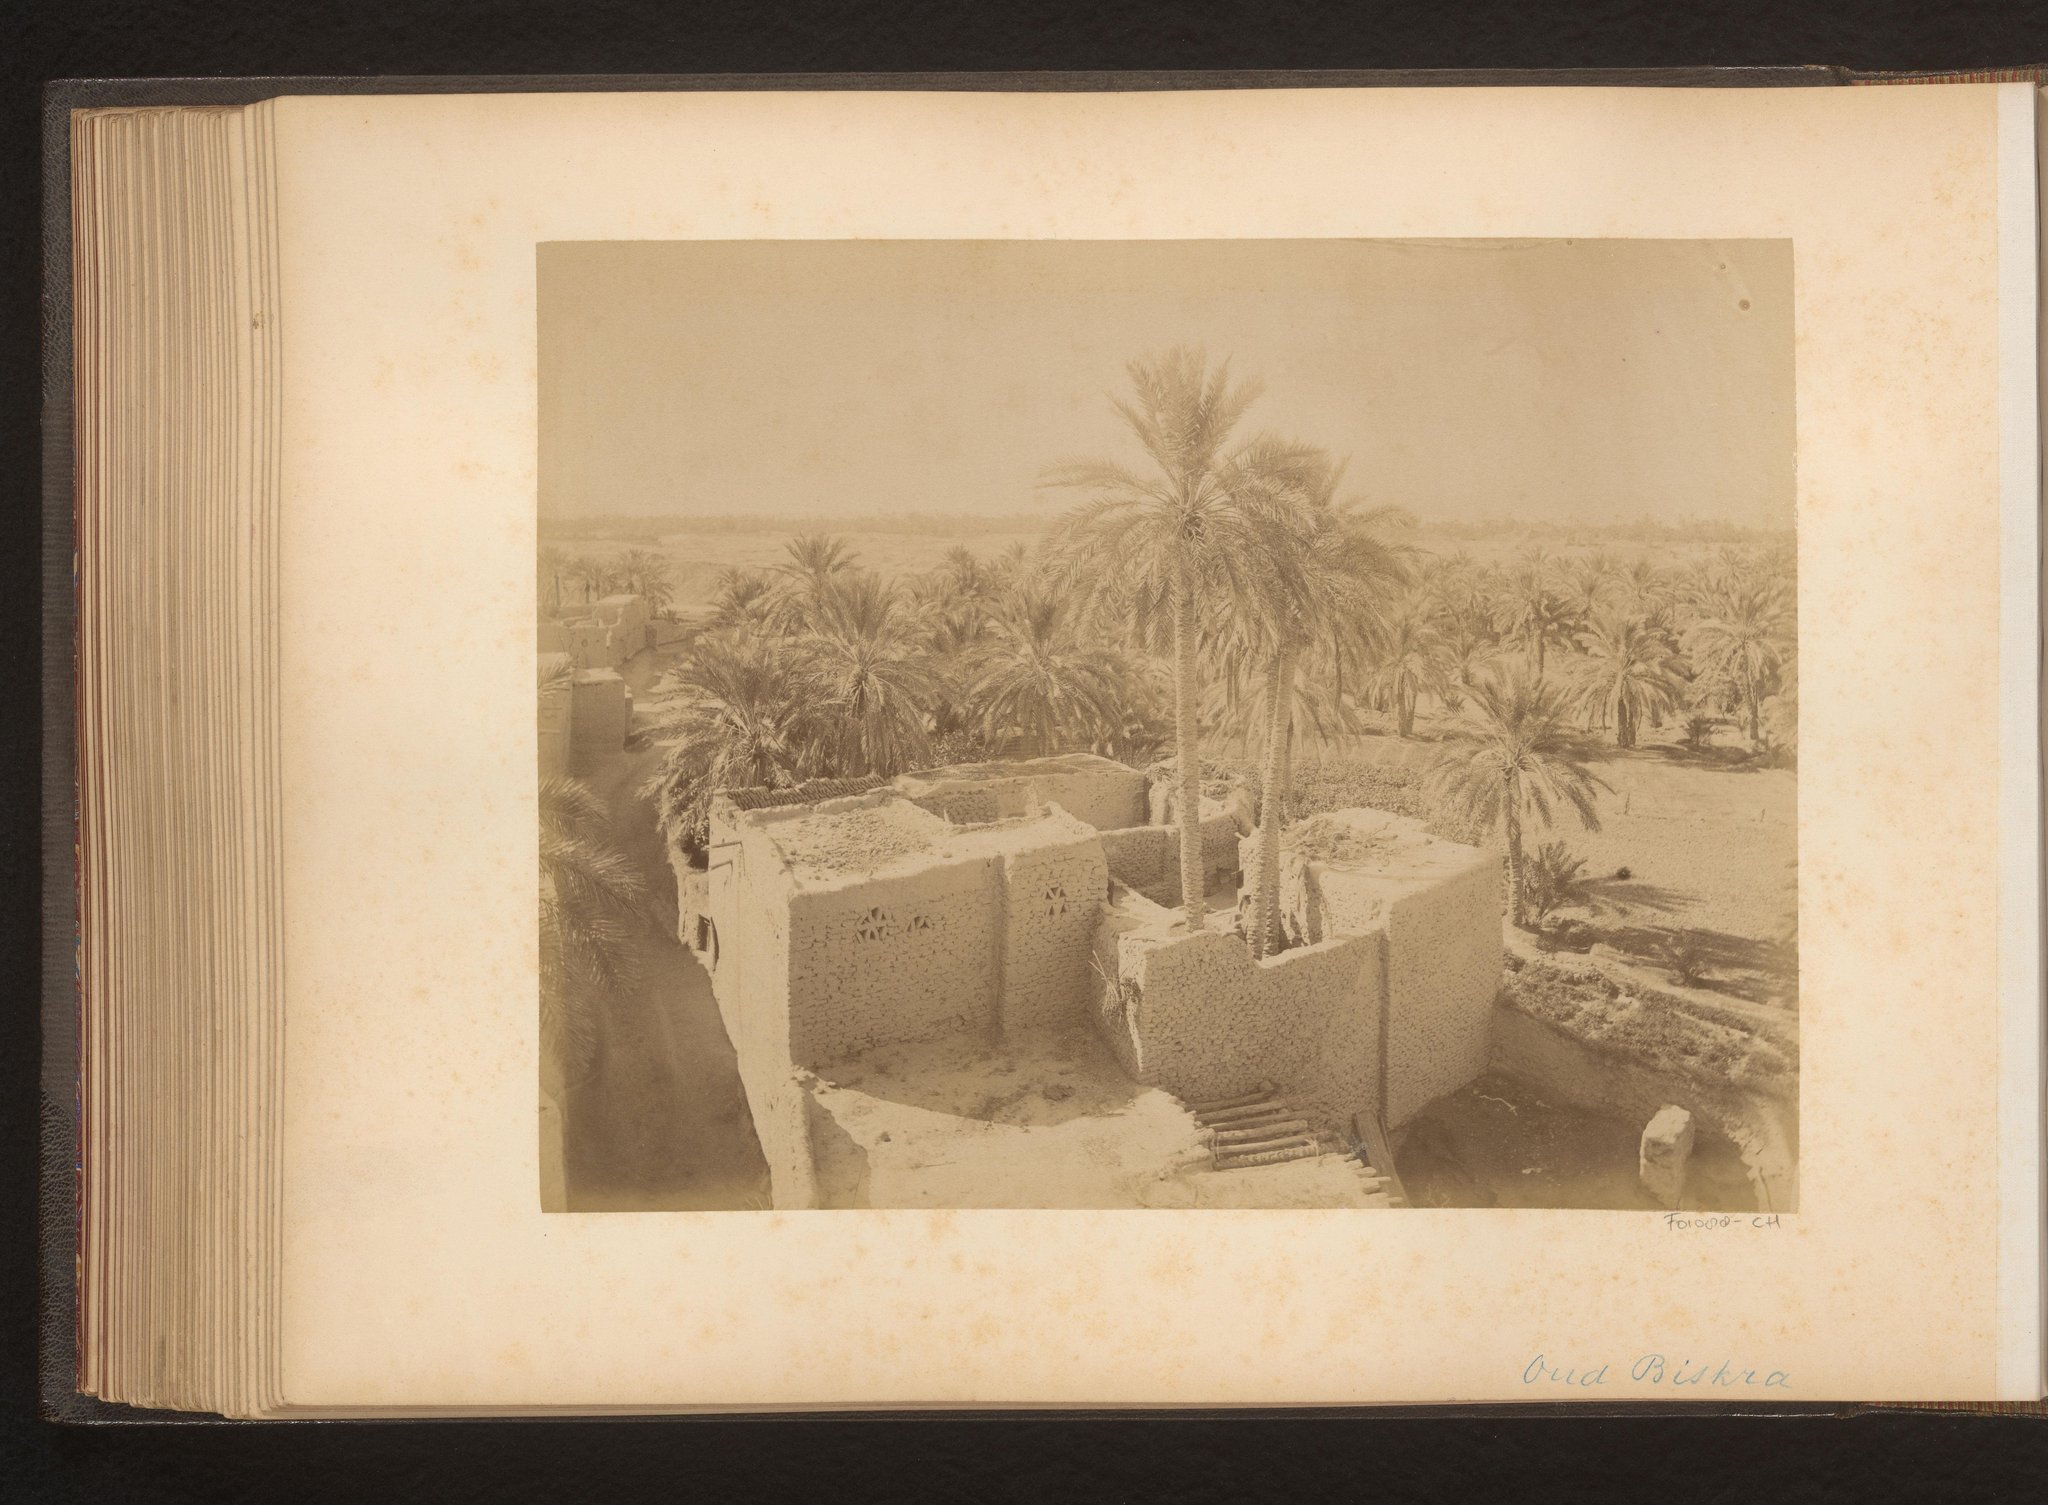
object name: album leaf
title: Bakstenen huis met palmbomen te Biskra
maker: Anonymous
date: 1880-1900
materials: photographic support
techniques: albumen print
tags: housing, trees: palm-tree